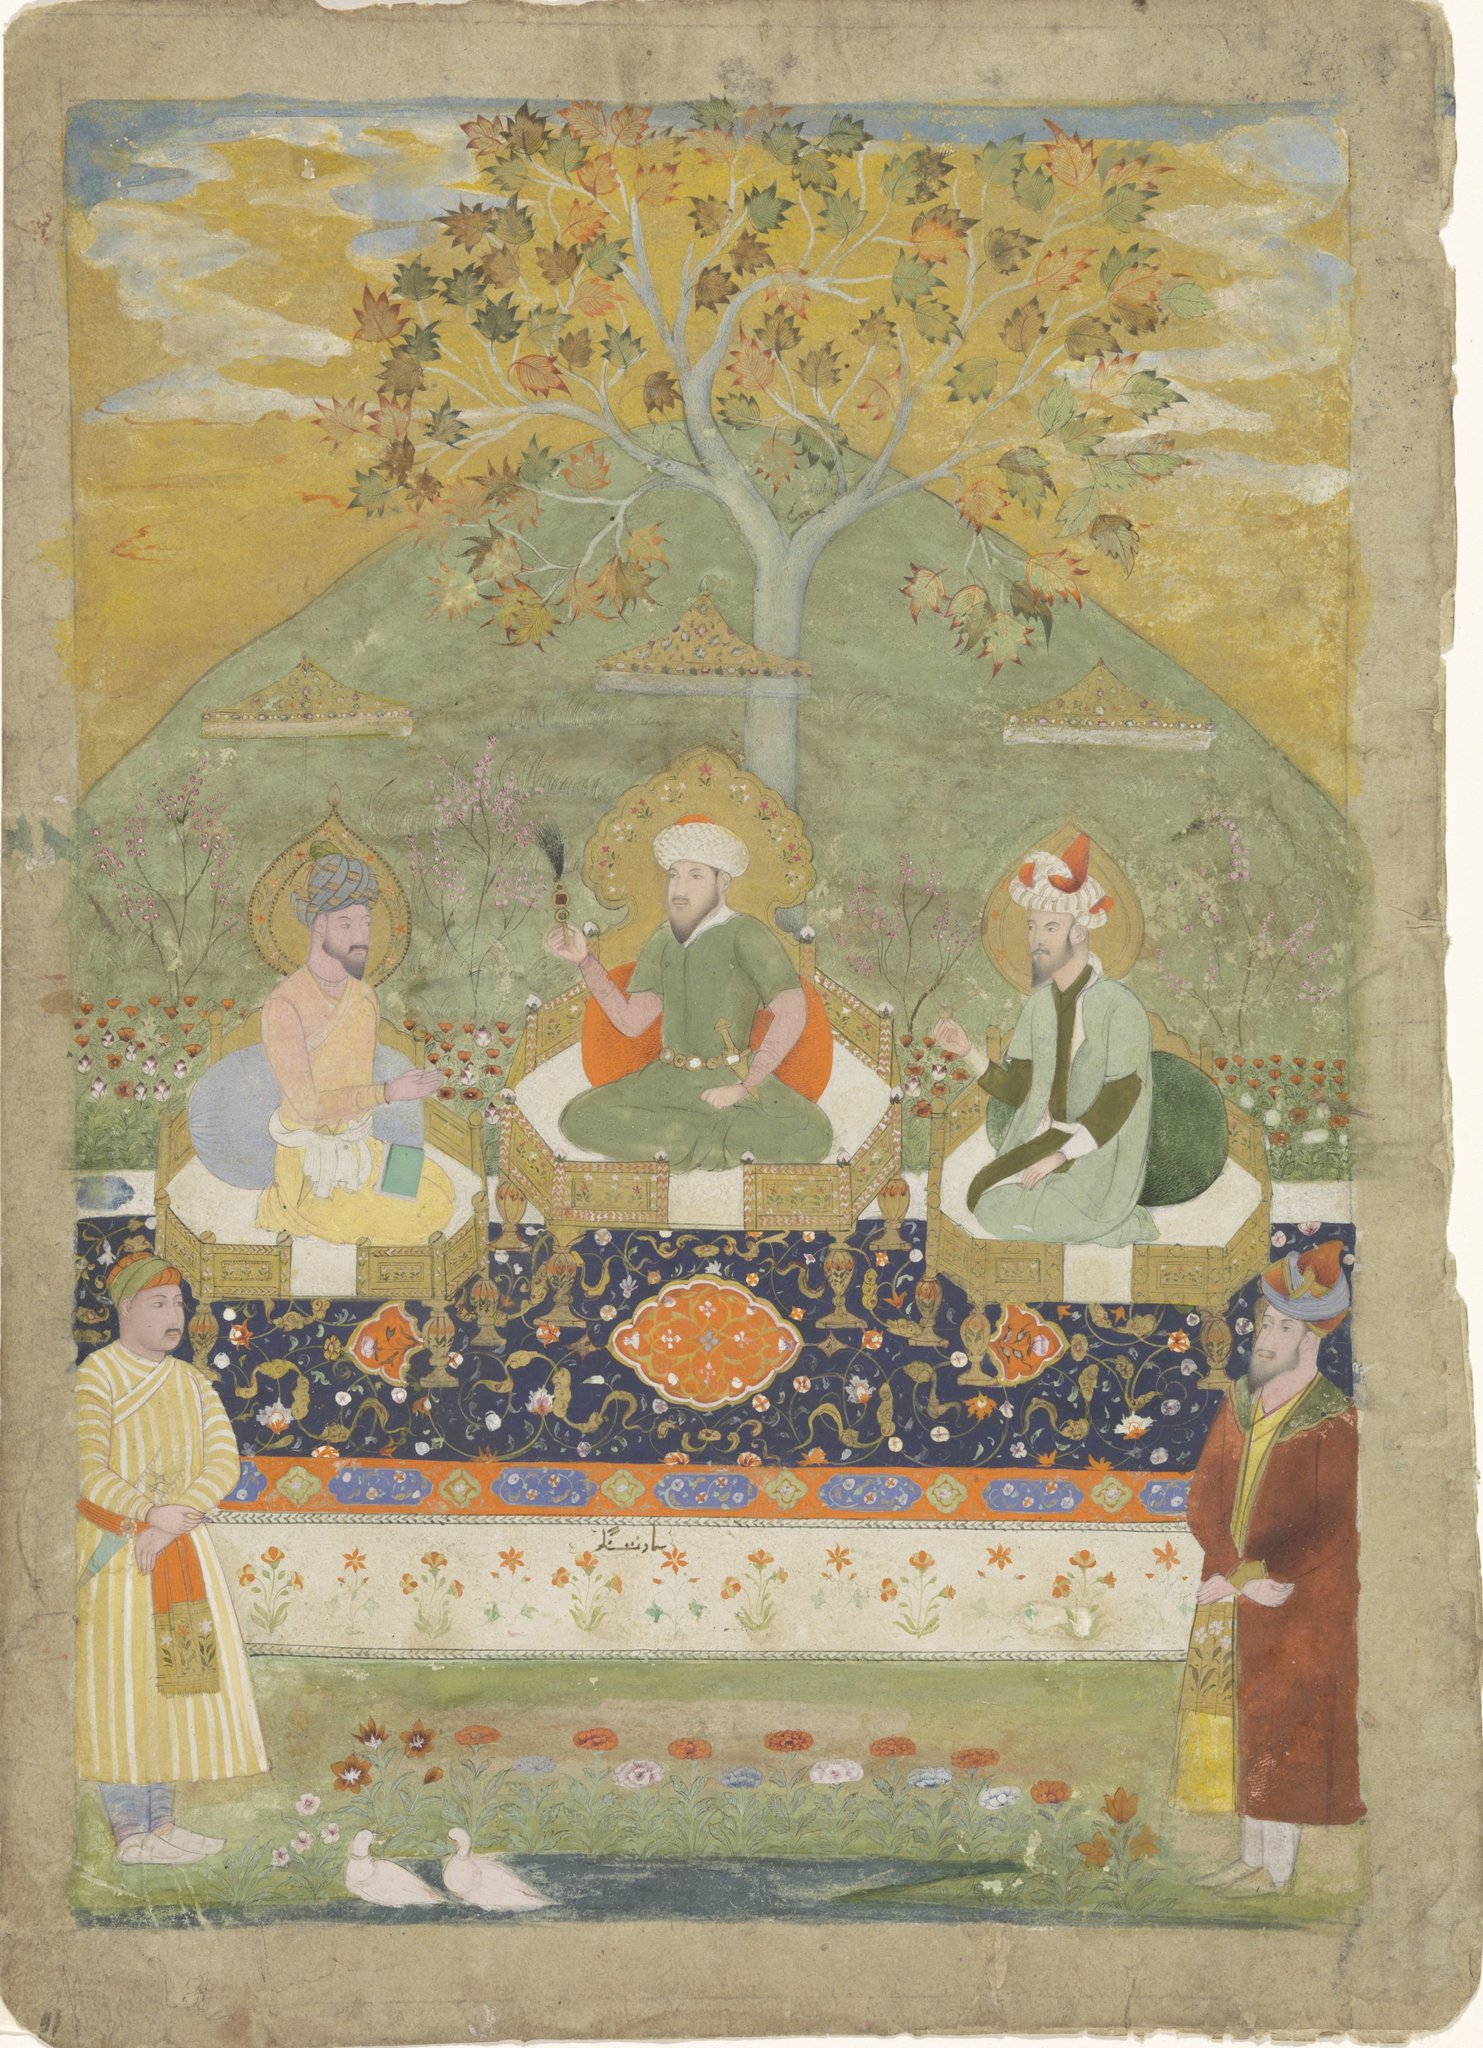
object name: indian miniature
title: Koning Timur en Nazaben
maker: Anonymous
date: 1700-1899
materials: paper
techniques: brush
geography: india